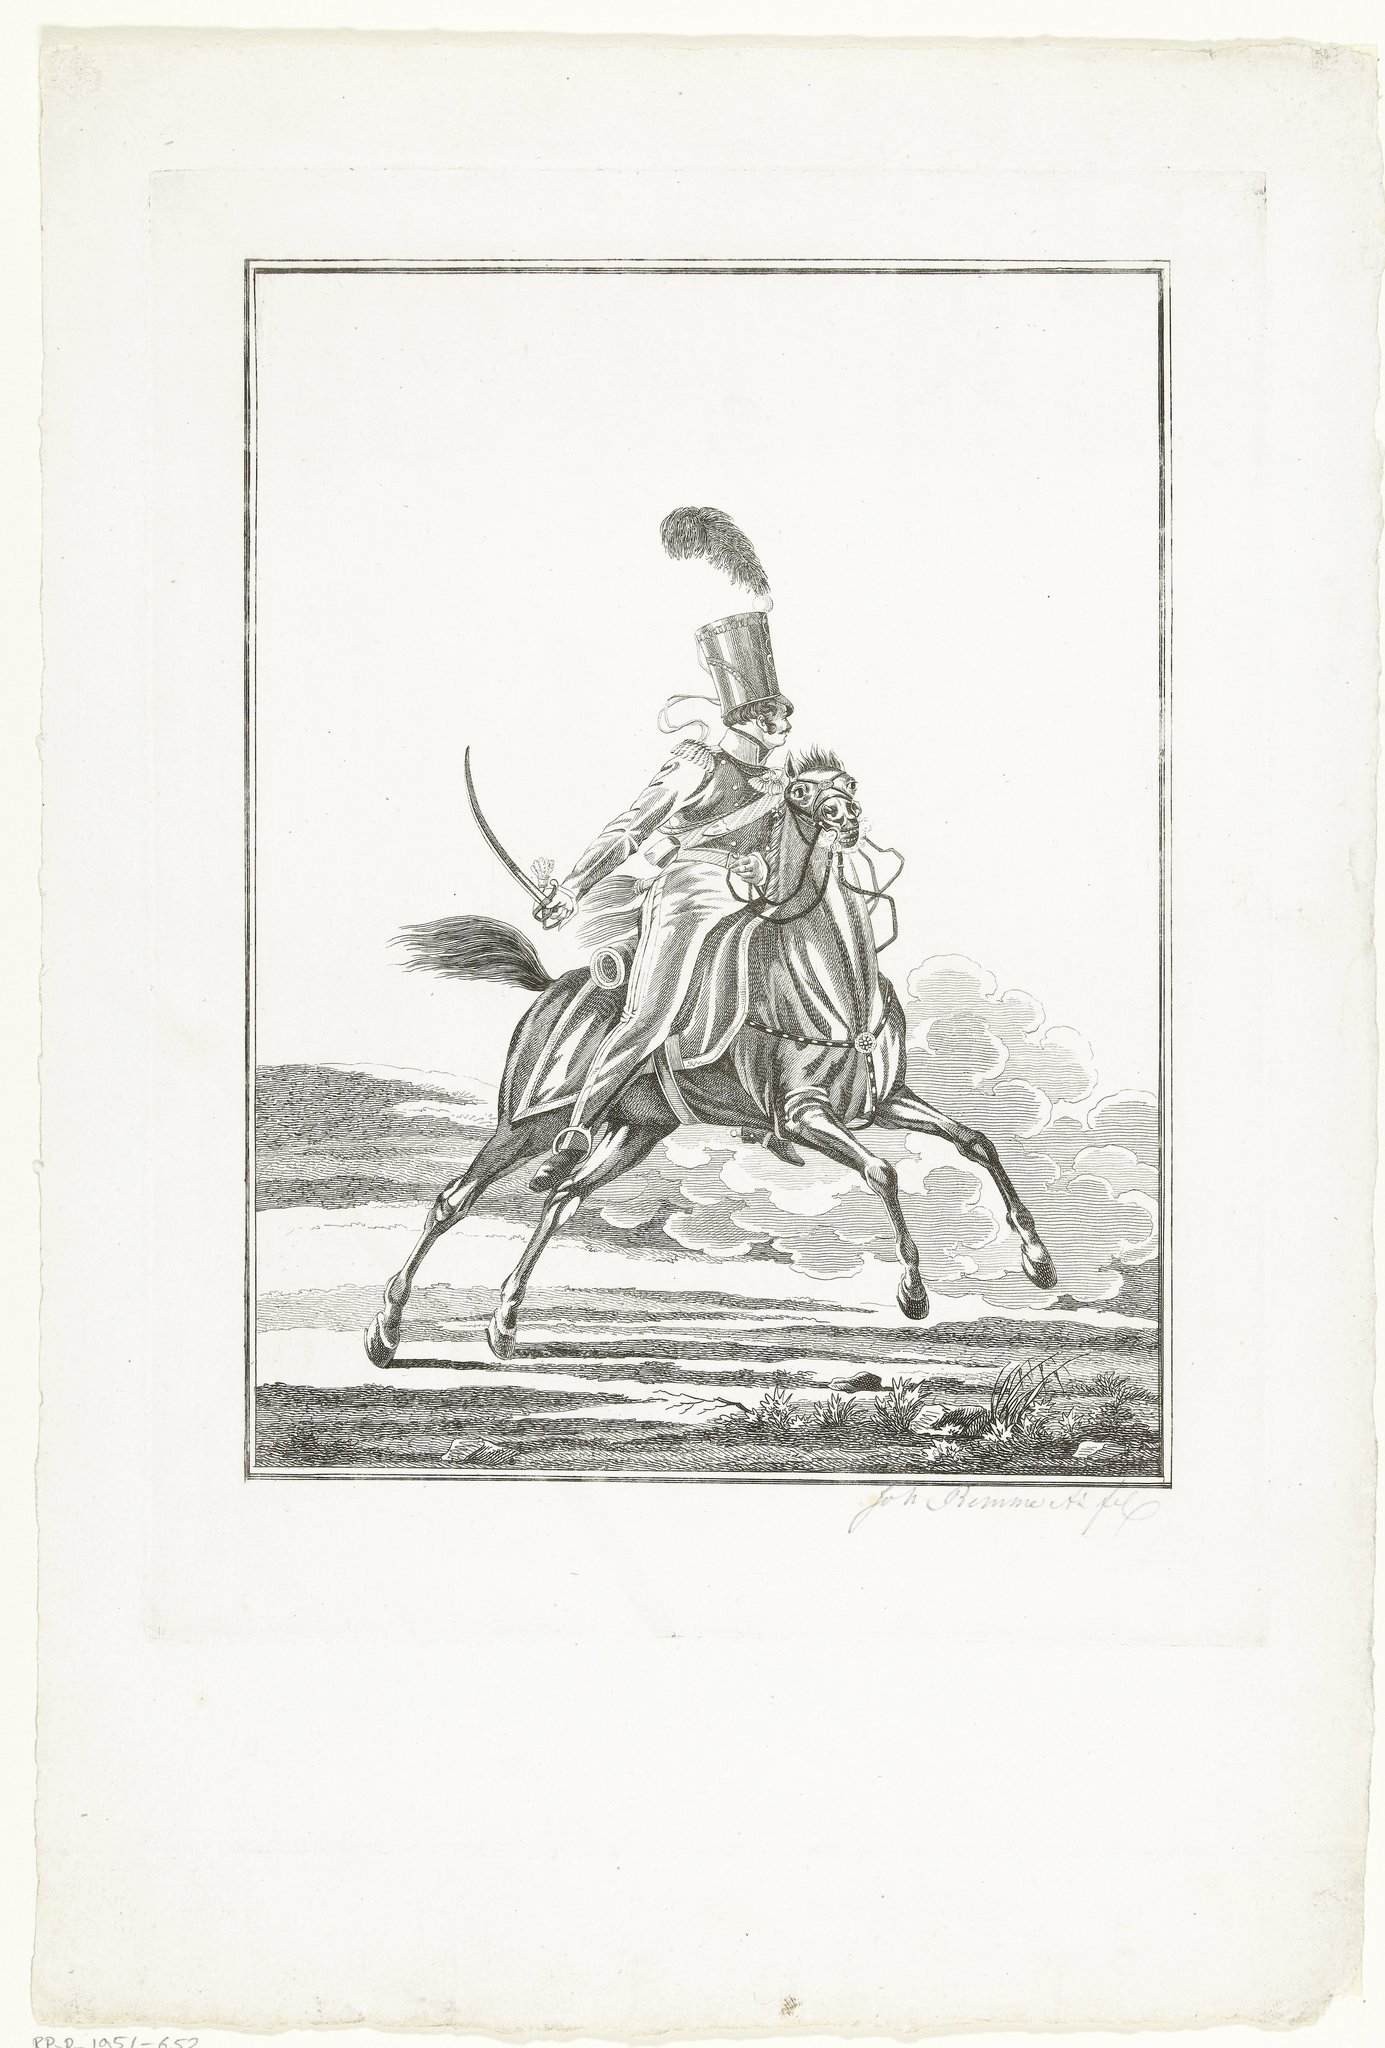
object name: print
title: Huzaar te paard, een charge uitvoerend, met een sabel in zijn hand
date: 1800-1841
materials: paper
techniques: etching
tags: warfare; military affairs (+ cavalry, horsemen)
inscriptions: collector's mark: Lugt 2228